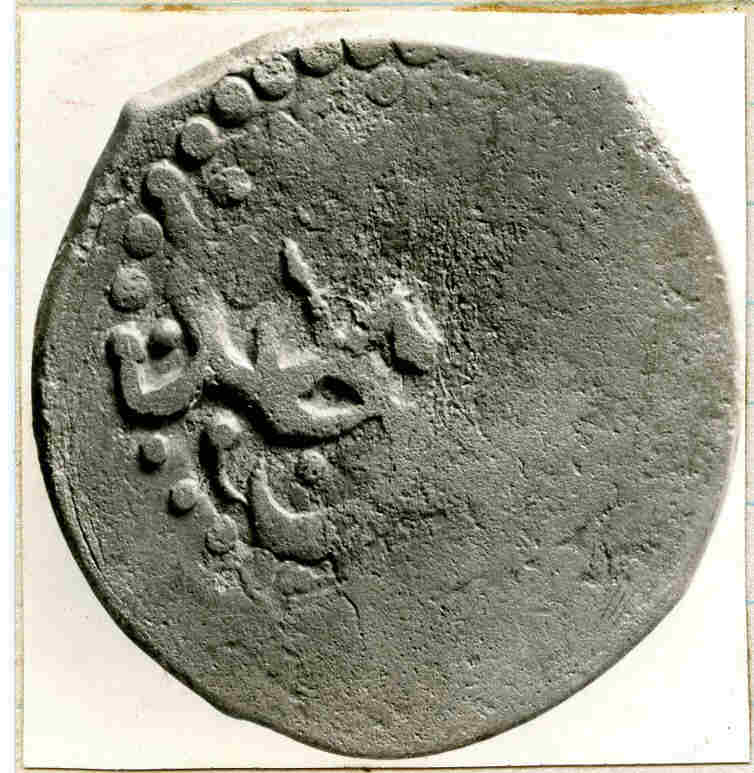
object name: coin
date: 1785-1925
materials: copper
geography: iran